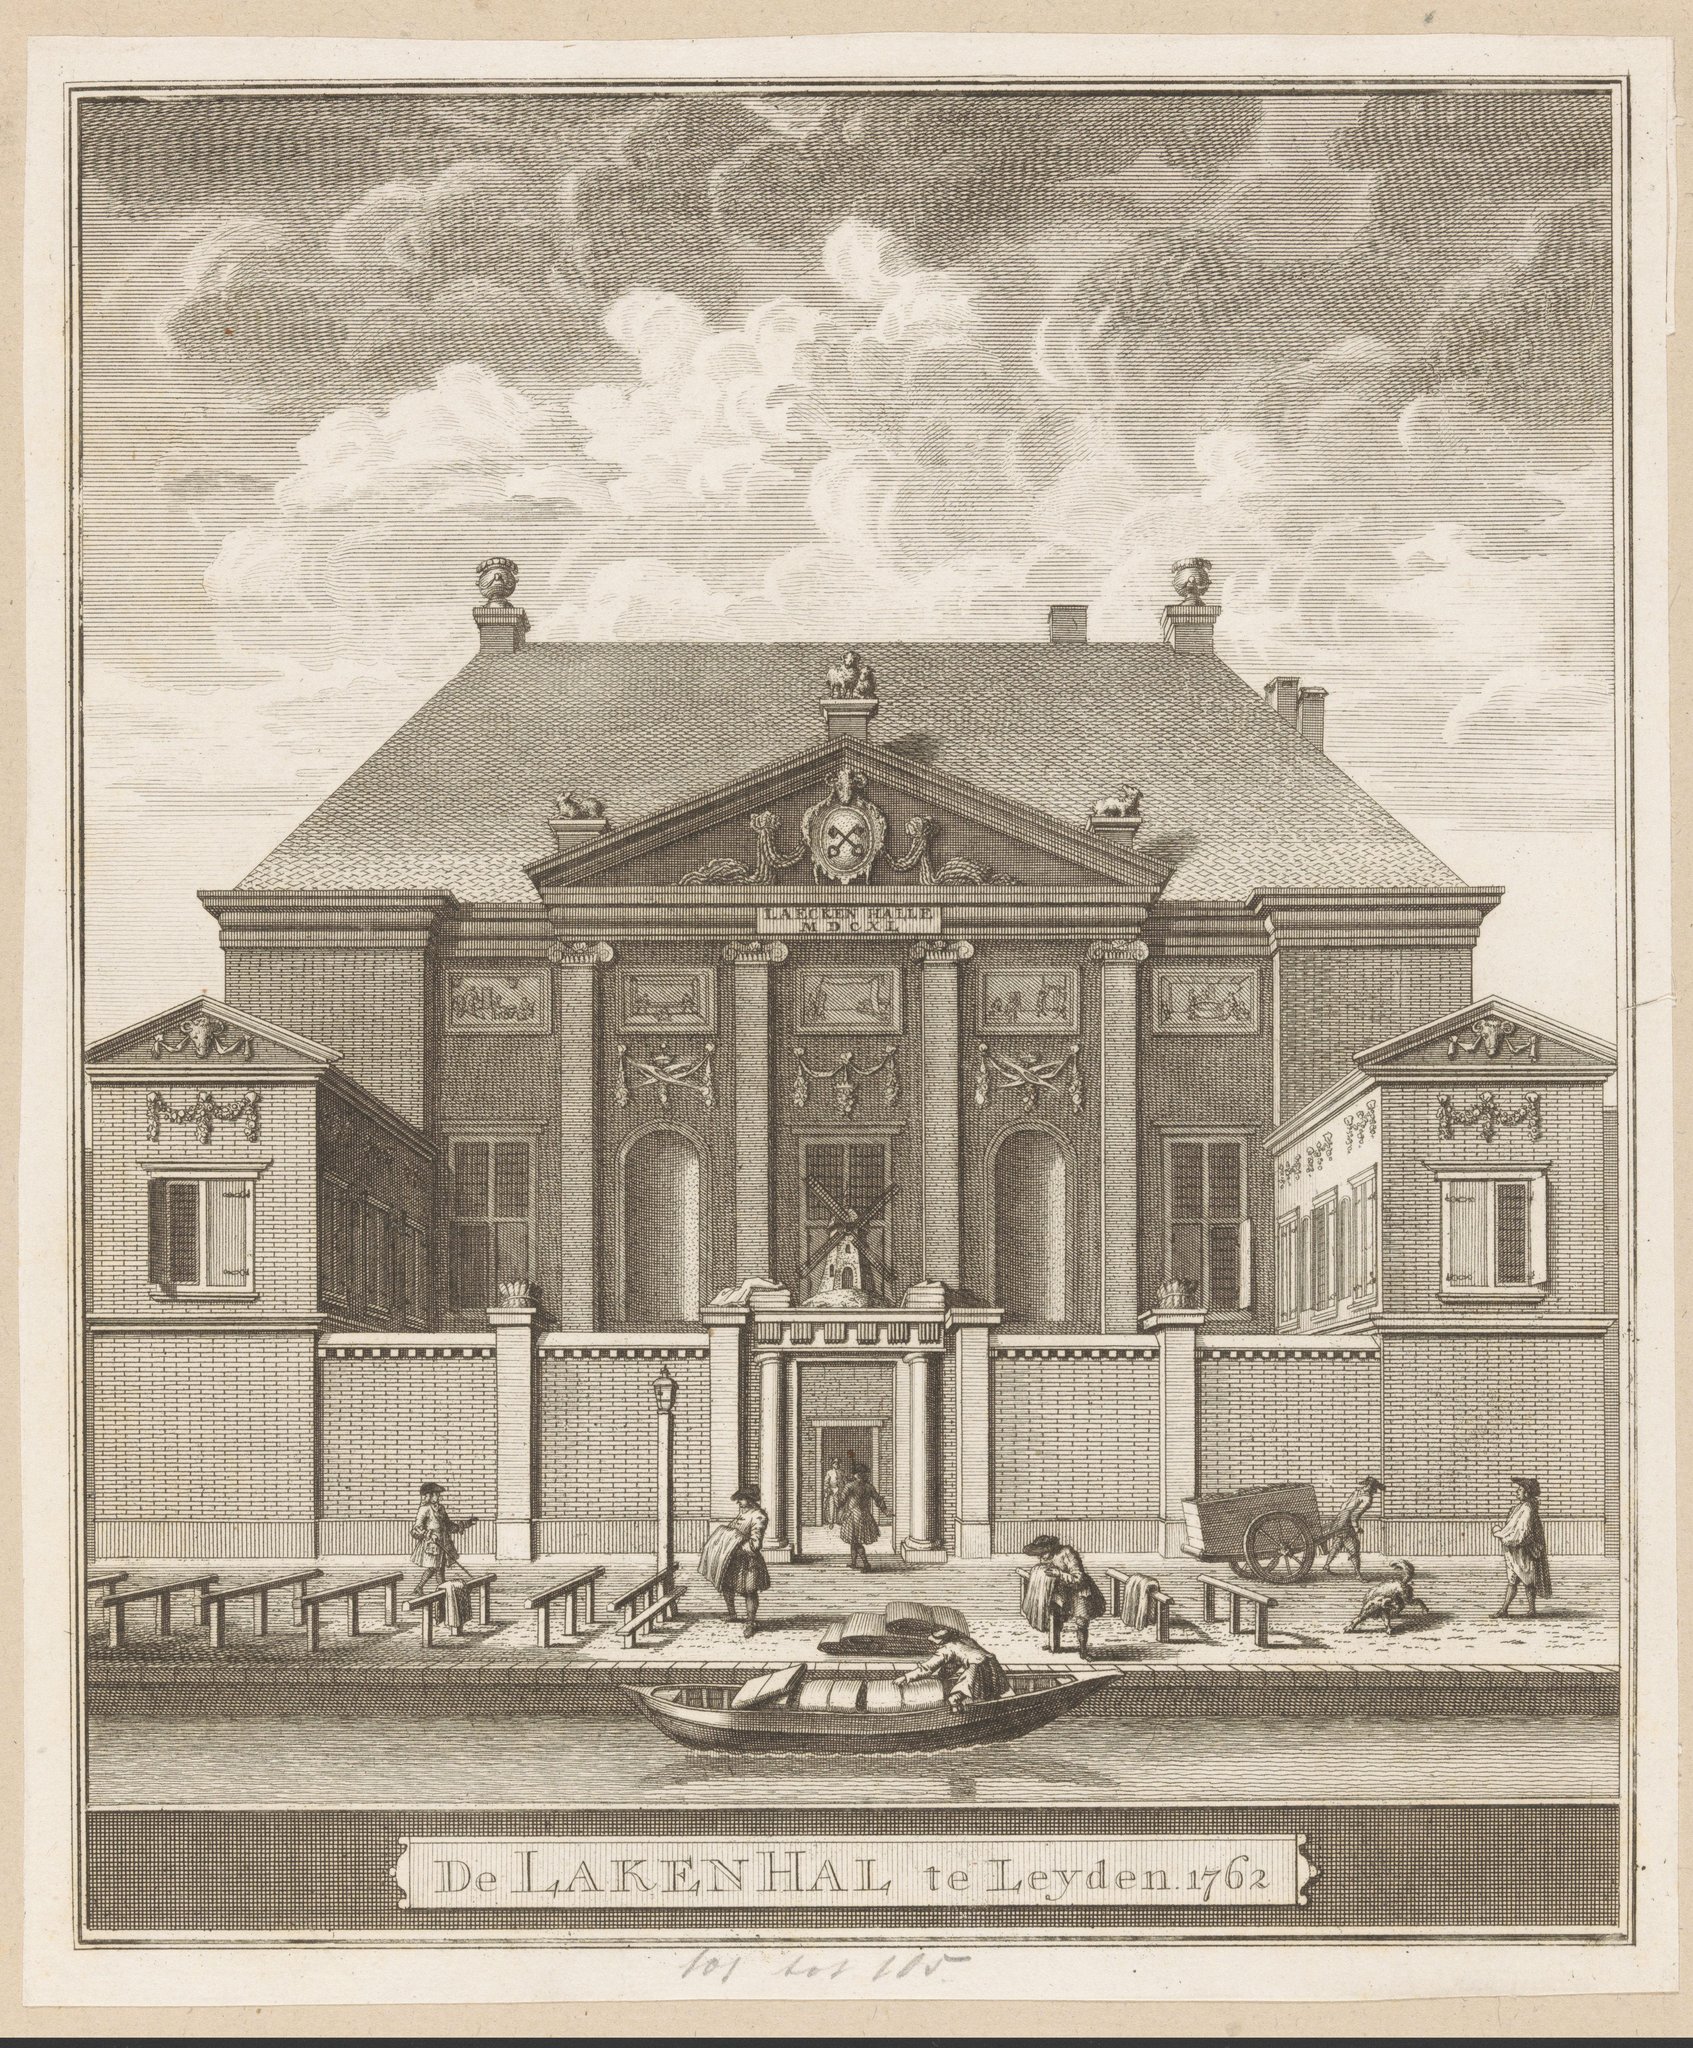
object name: book illustration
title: De Lakenhal te Leyden. 1762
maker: Anonymous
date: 1762-1770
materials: paper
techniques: engraving, etching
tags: civic architecture; edifices; dwellings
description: Prent ook gebruikt in: Mieris, Frans van (II). Beschryving der stad Leyden, haare gelegenheid, oorsprong, vergrootinge, oude en hedendaagsche gedaante (…). 3 delen. Leiden: weduwe Abraham Honkoop, Cornelis van Hoogeveen junior e.a., 1762-1784, dl. 2 (1770), tussen p. 462 en 463.